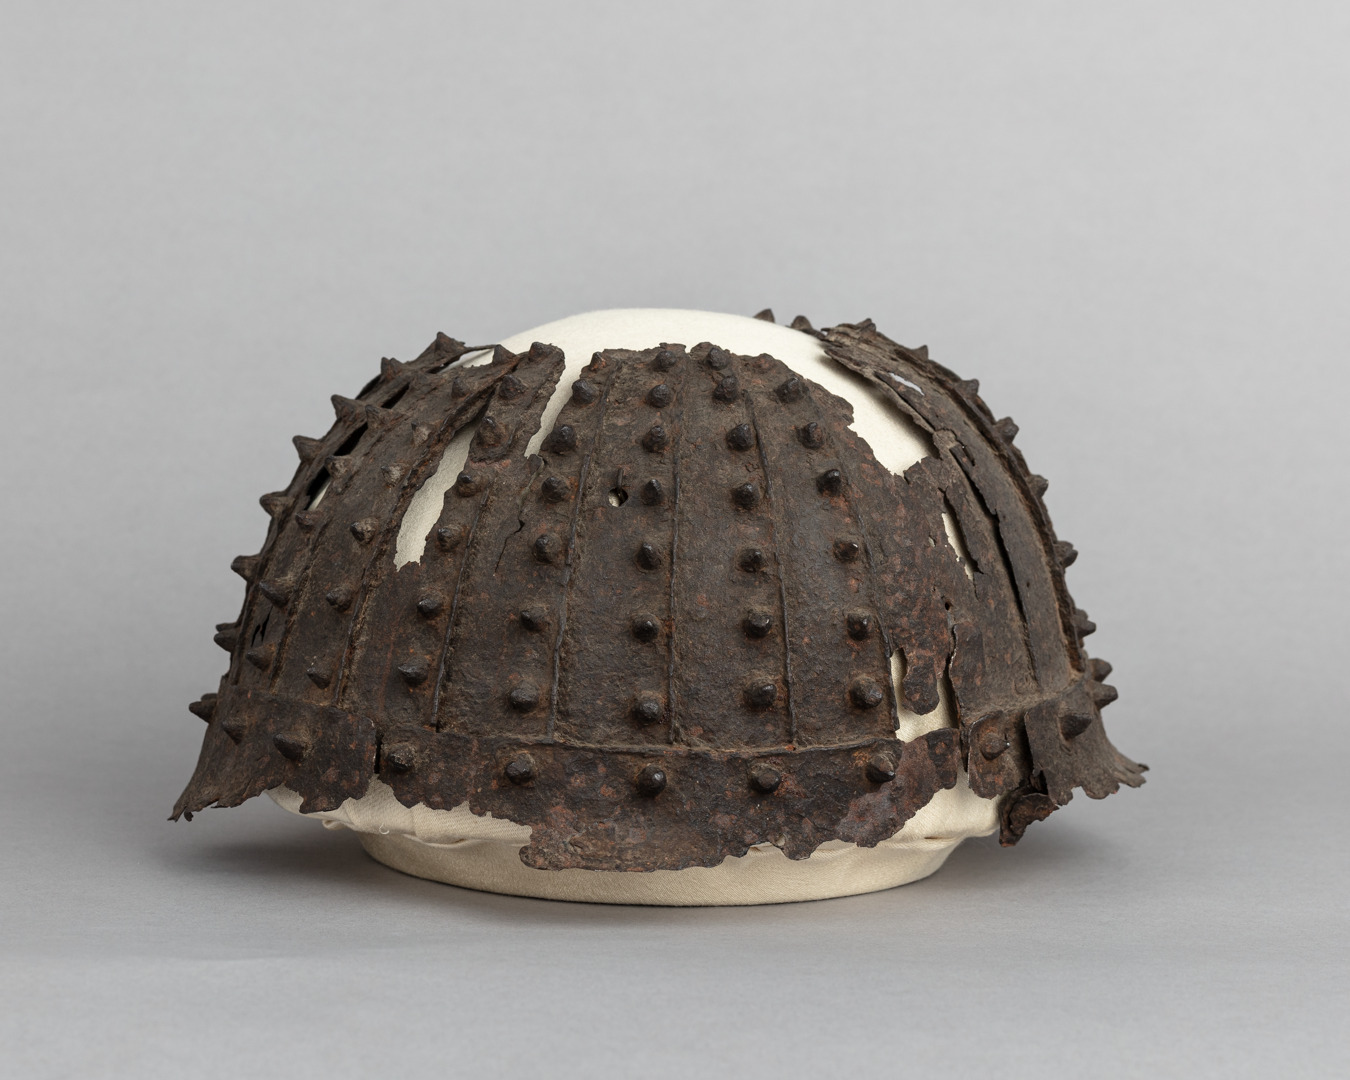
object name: helmet bowl i hoshi kabutobachi i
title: Helmet Bowl (Hoshi-Kabutobachi)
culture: japanese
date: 1101-1300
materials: steel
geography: japan